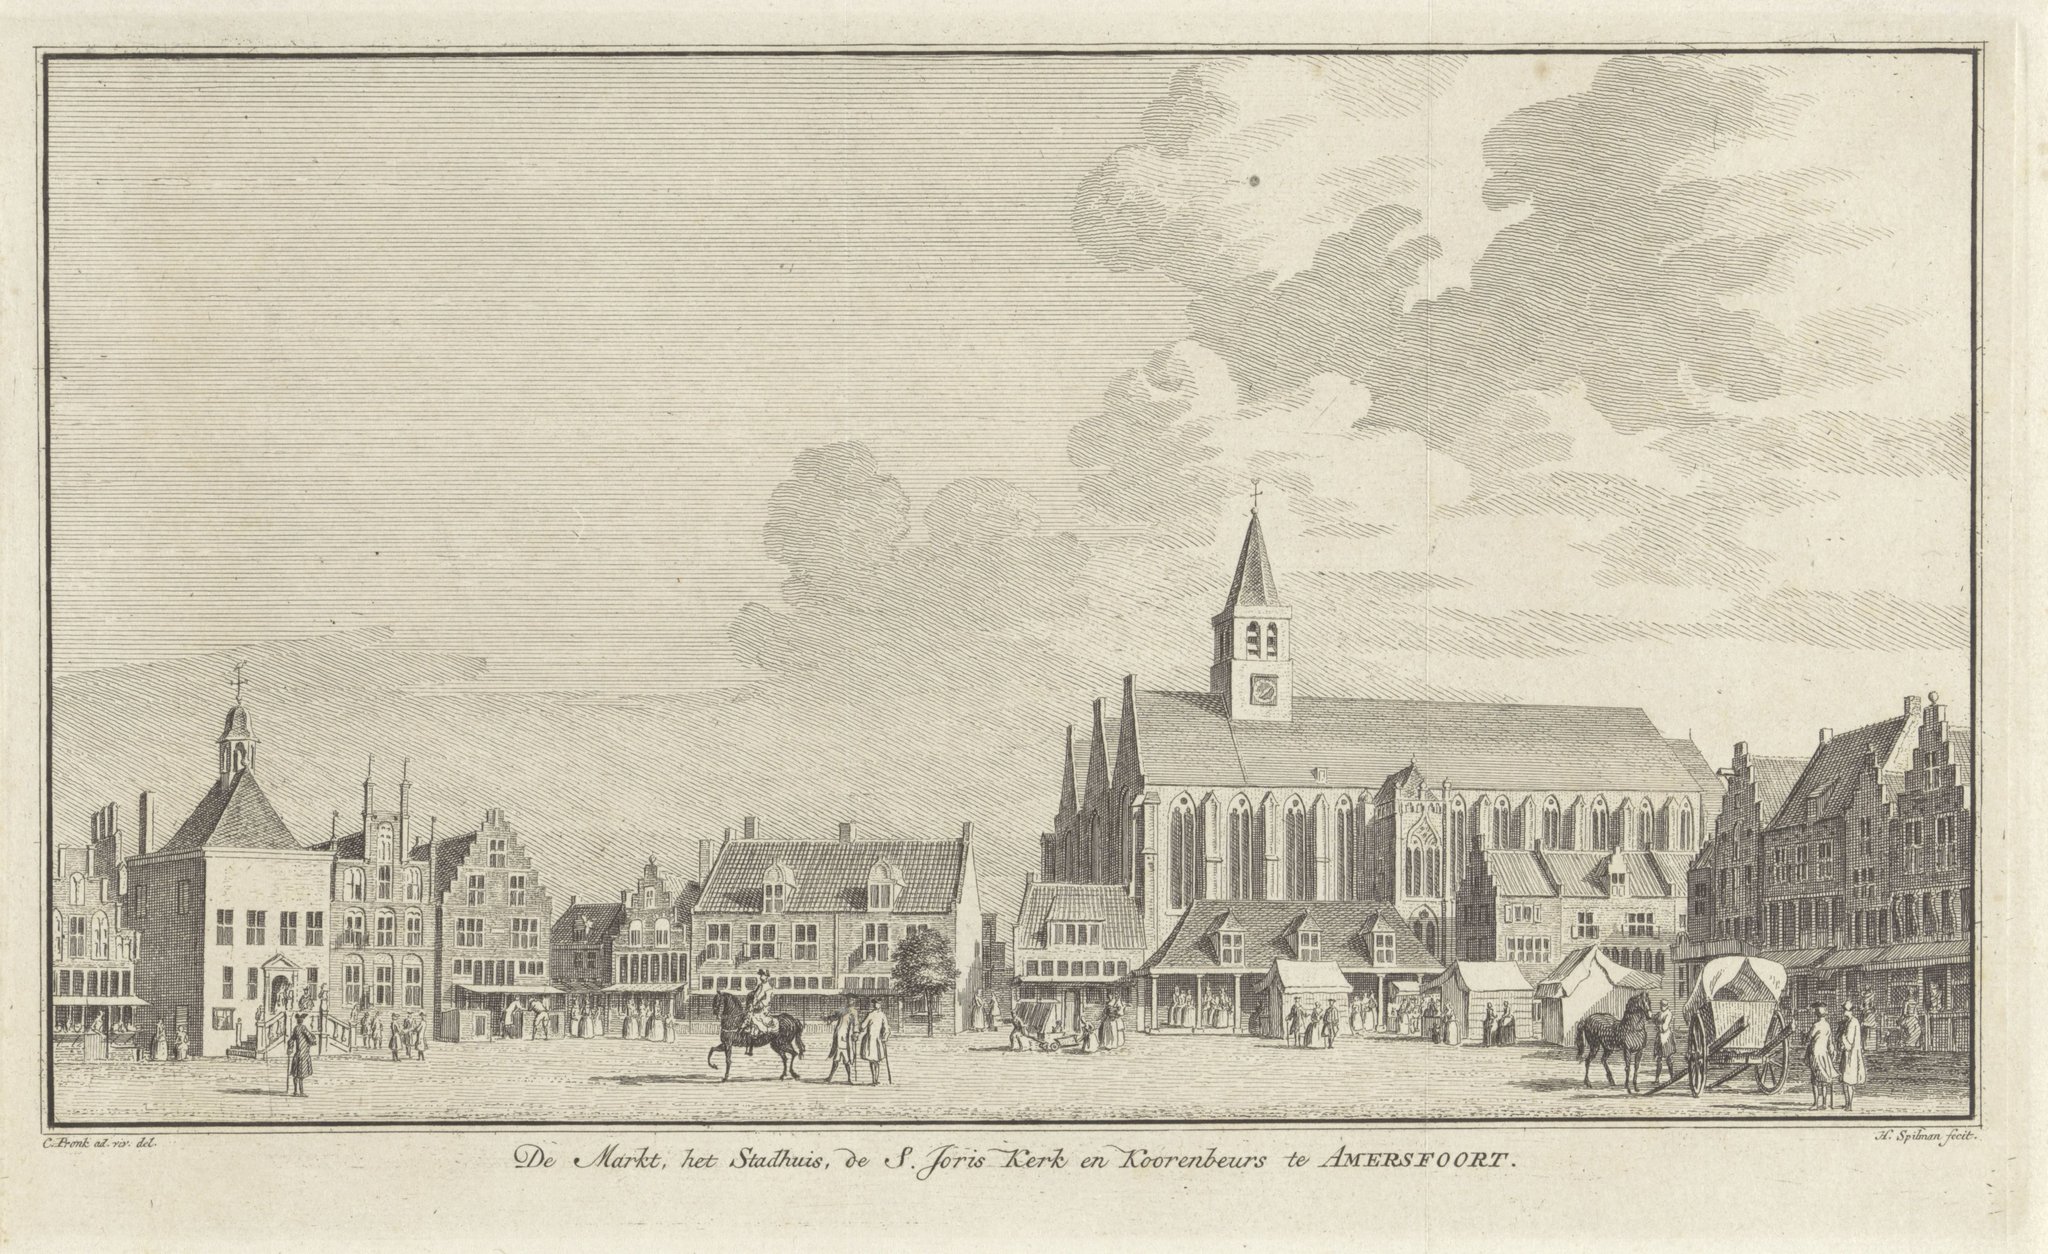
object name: print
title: Gezicht op Amersfoort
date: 1742-1784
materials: paper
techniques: etching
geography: haarlem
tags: square, place, circus, etc.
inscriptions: collector's mark: Lugt 2228